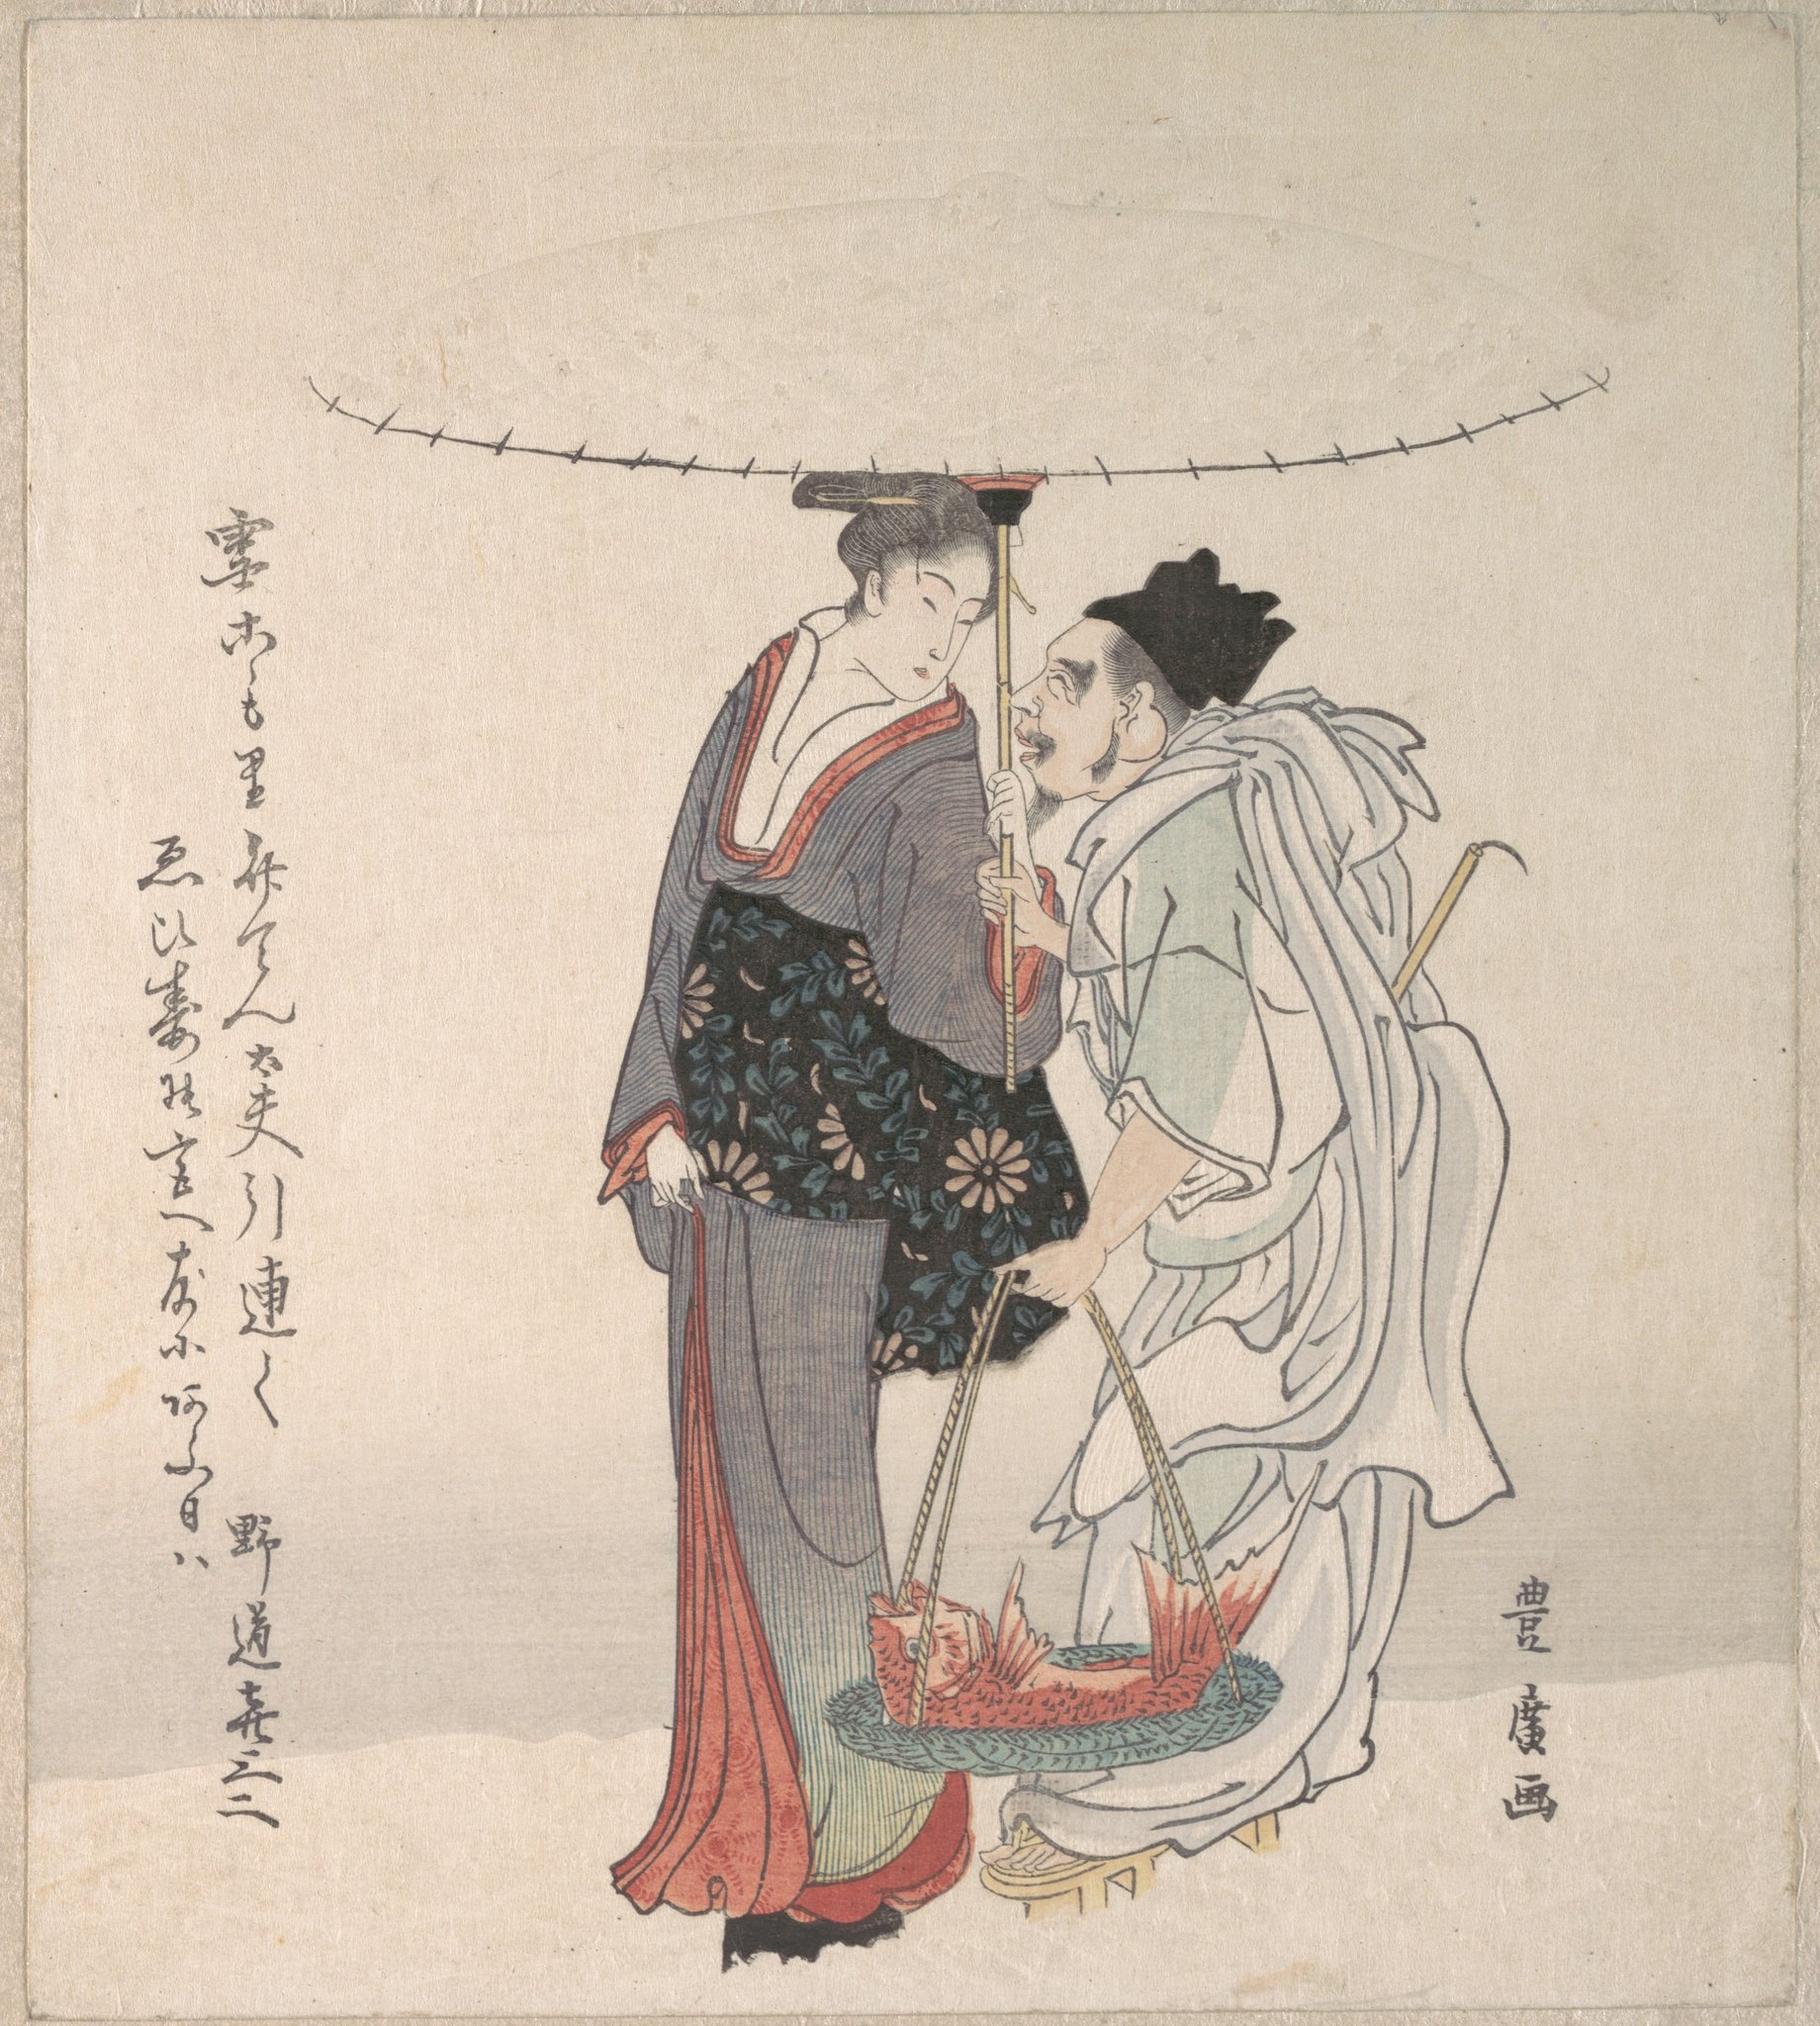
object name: print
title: Ebisu and Benten Walking in the Snow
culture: japanese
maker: utagawa toyohiro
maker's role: artist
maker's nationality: japanese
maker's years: 1763-1828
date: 1763-1828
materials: ink, paper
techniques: surimono, woodblock print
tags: men,women,walking,snow